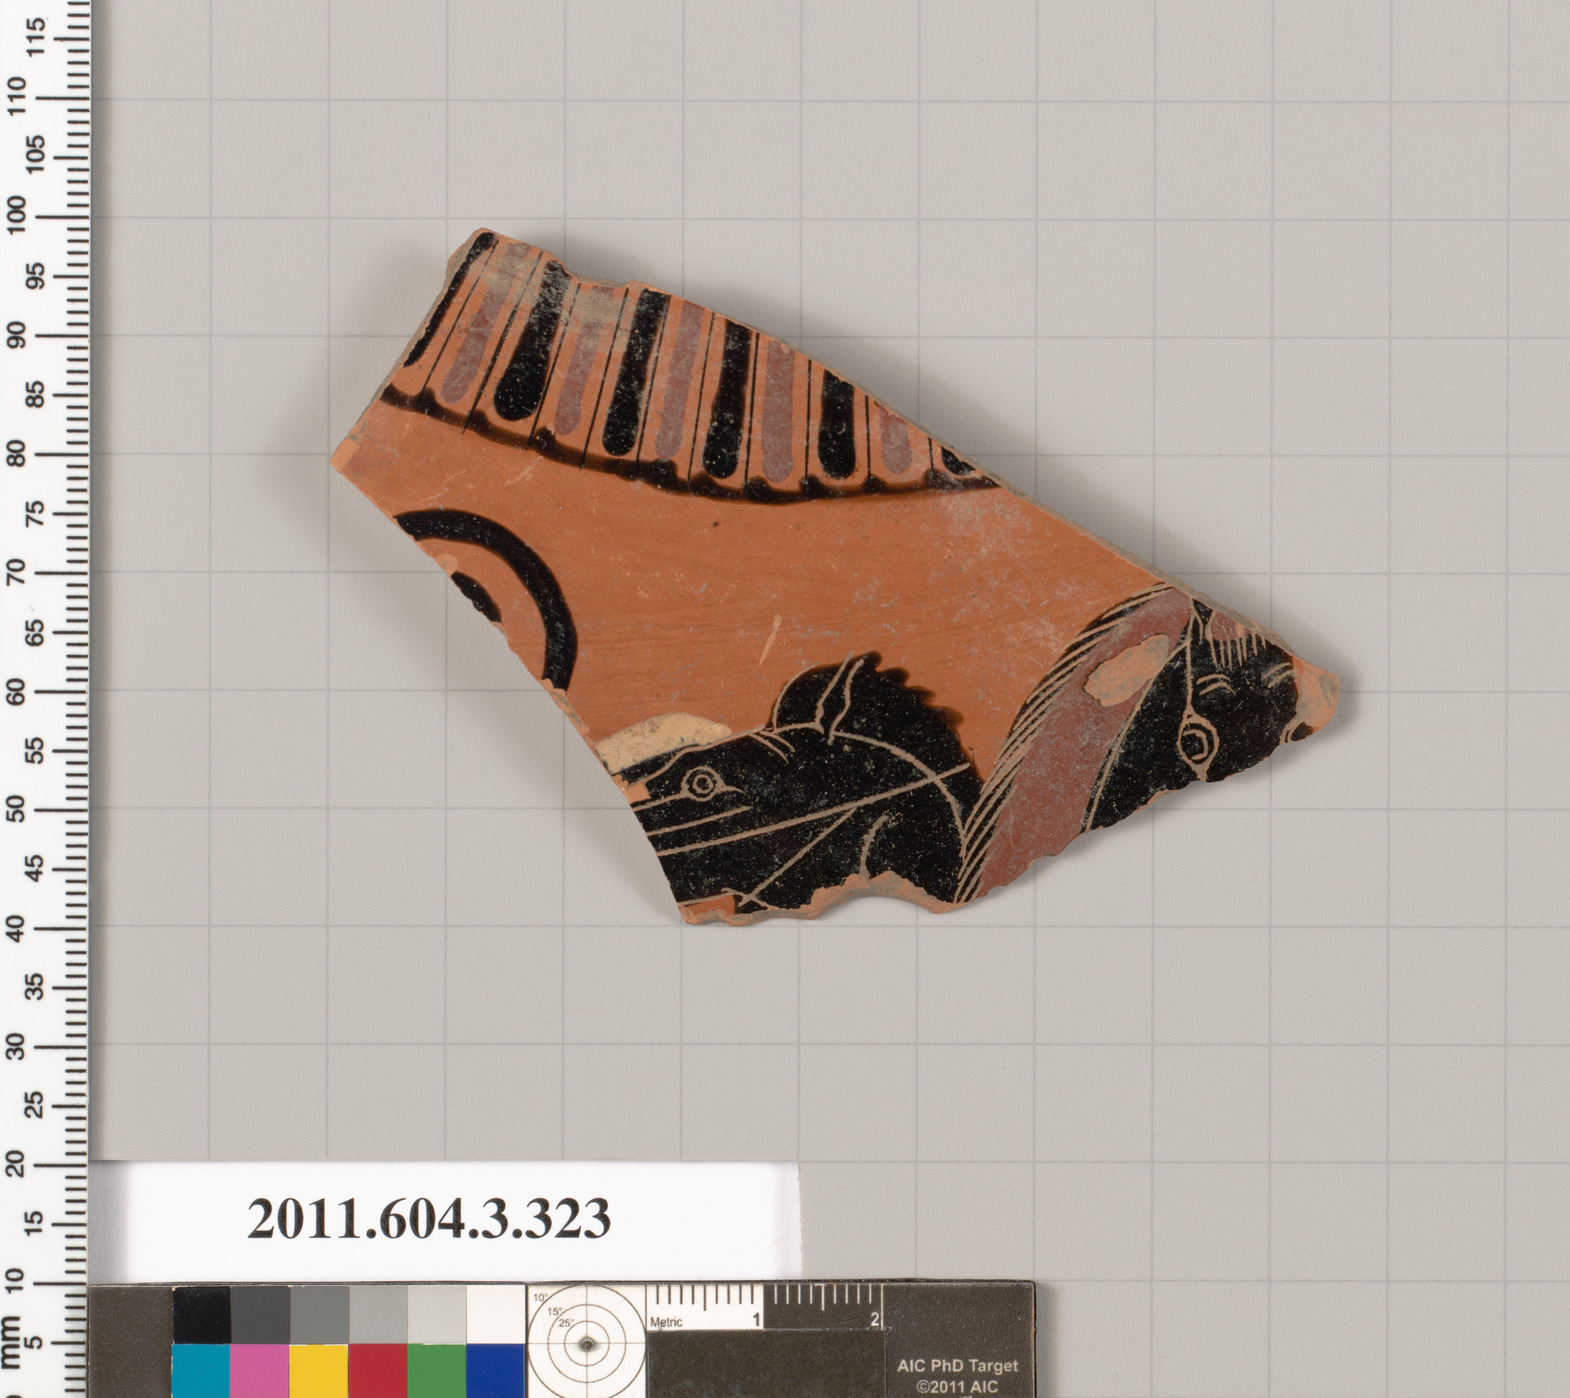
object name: neck amphora fragment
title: Terracotta fragment of a neck-amphora (jar)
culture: greek, attic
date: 525-501 BCE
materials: terracotta